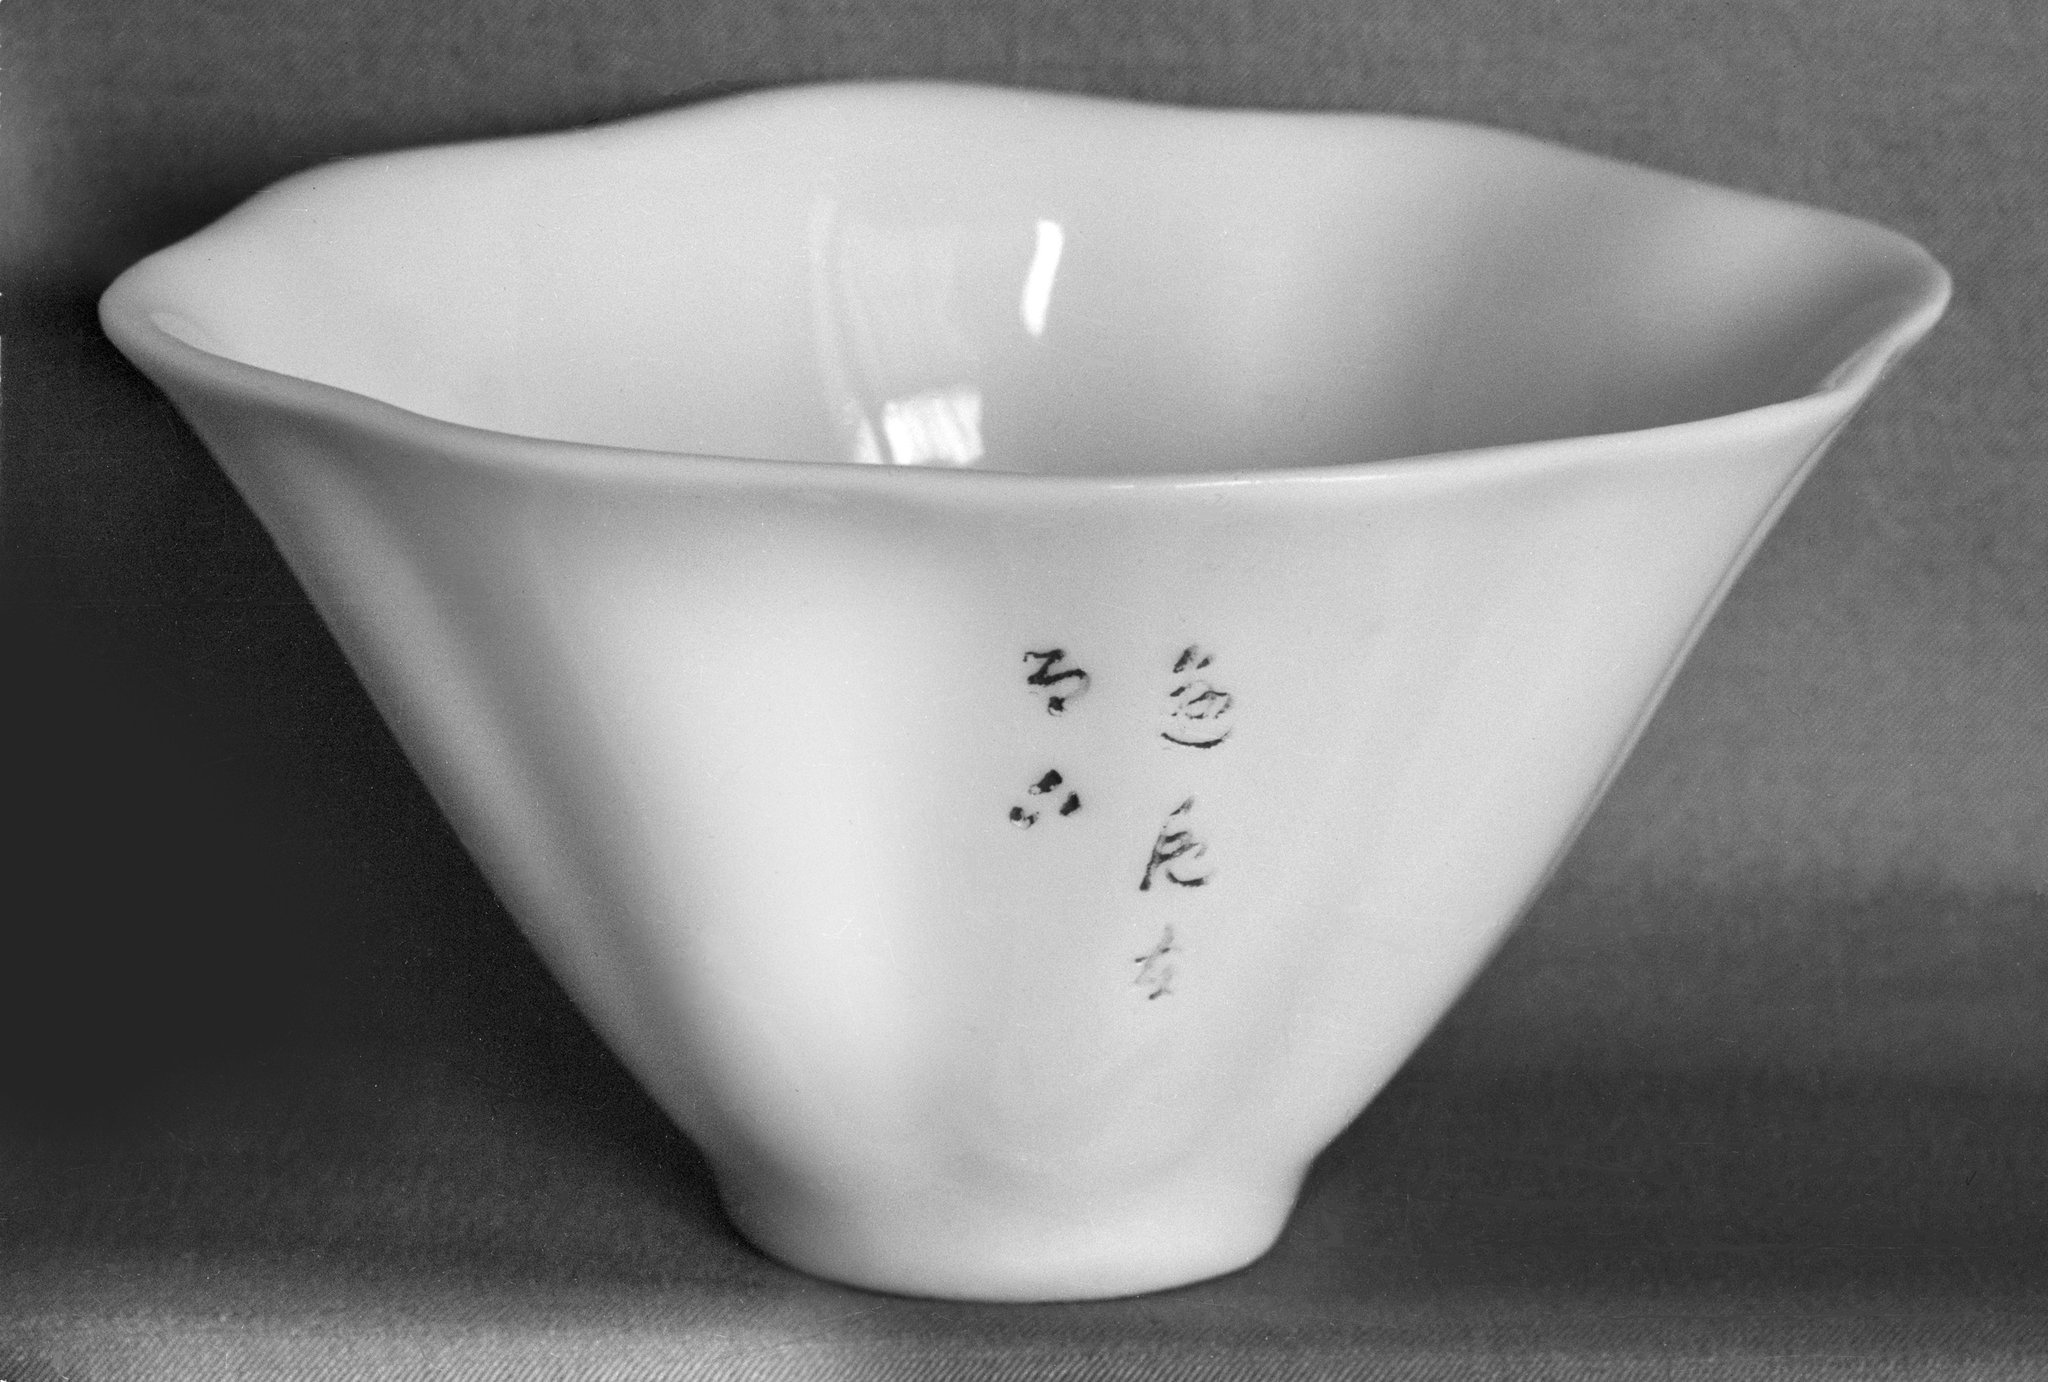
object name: cup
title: Cup with poem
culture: chinese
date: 1667-1733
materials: porcelain